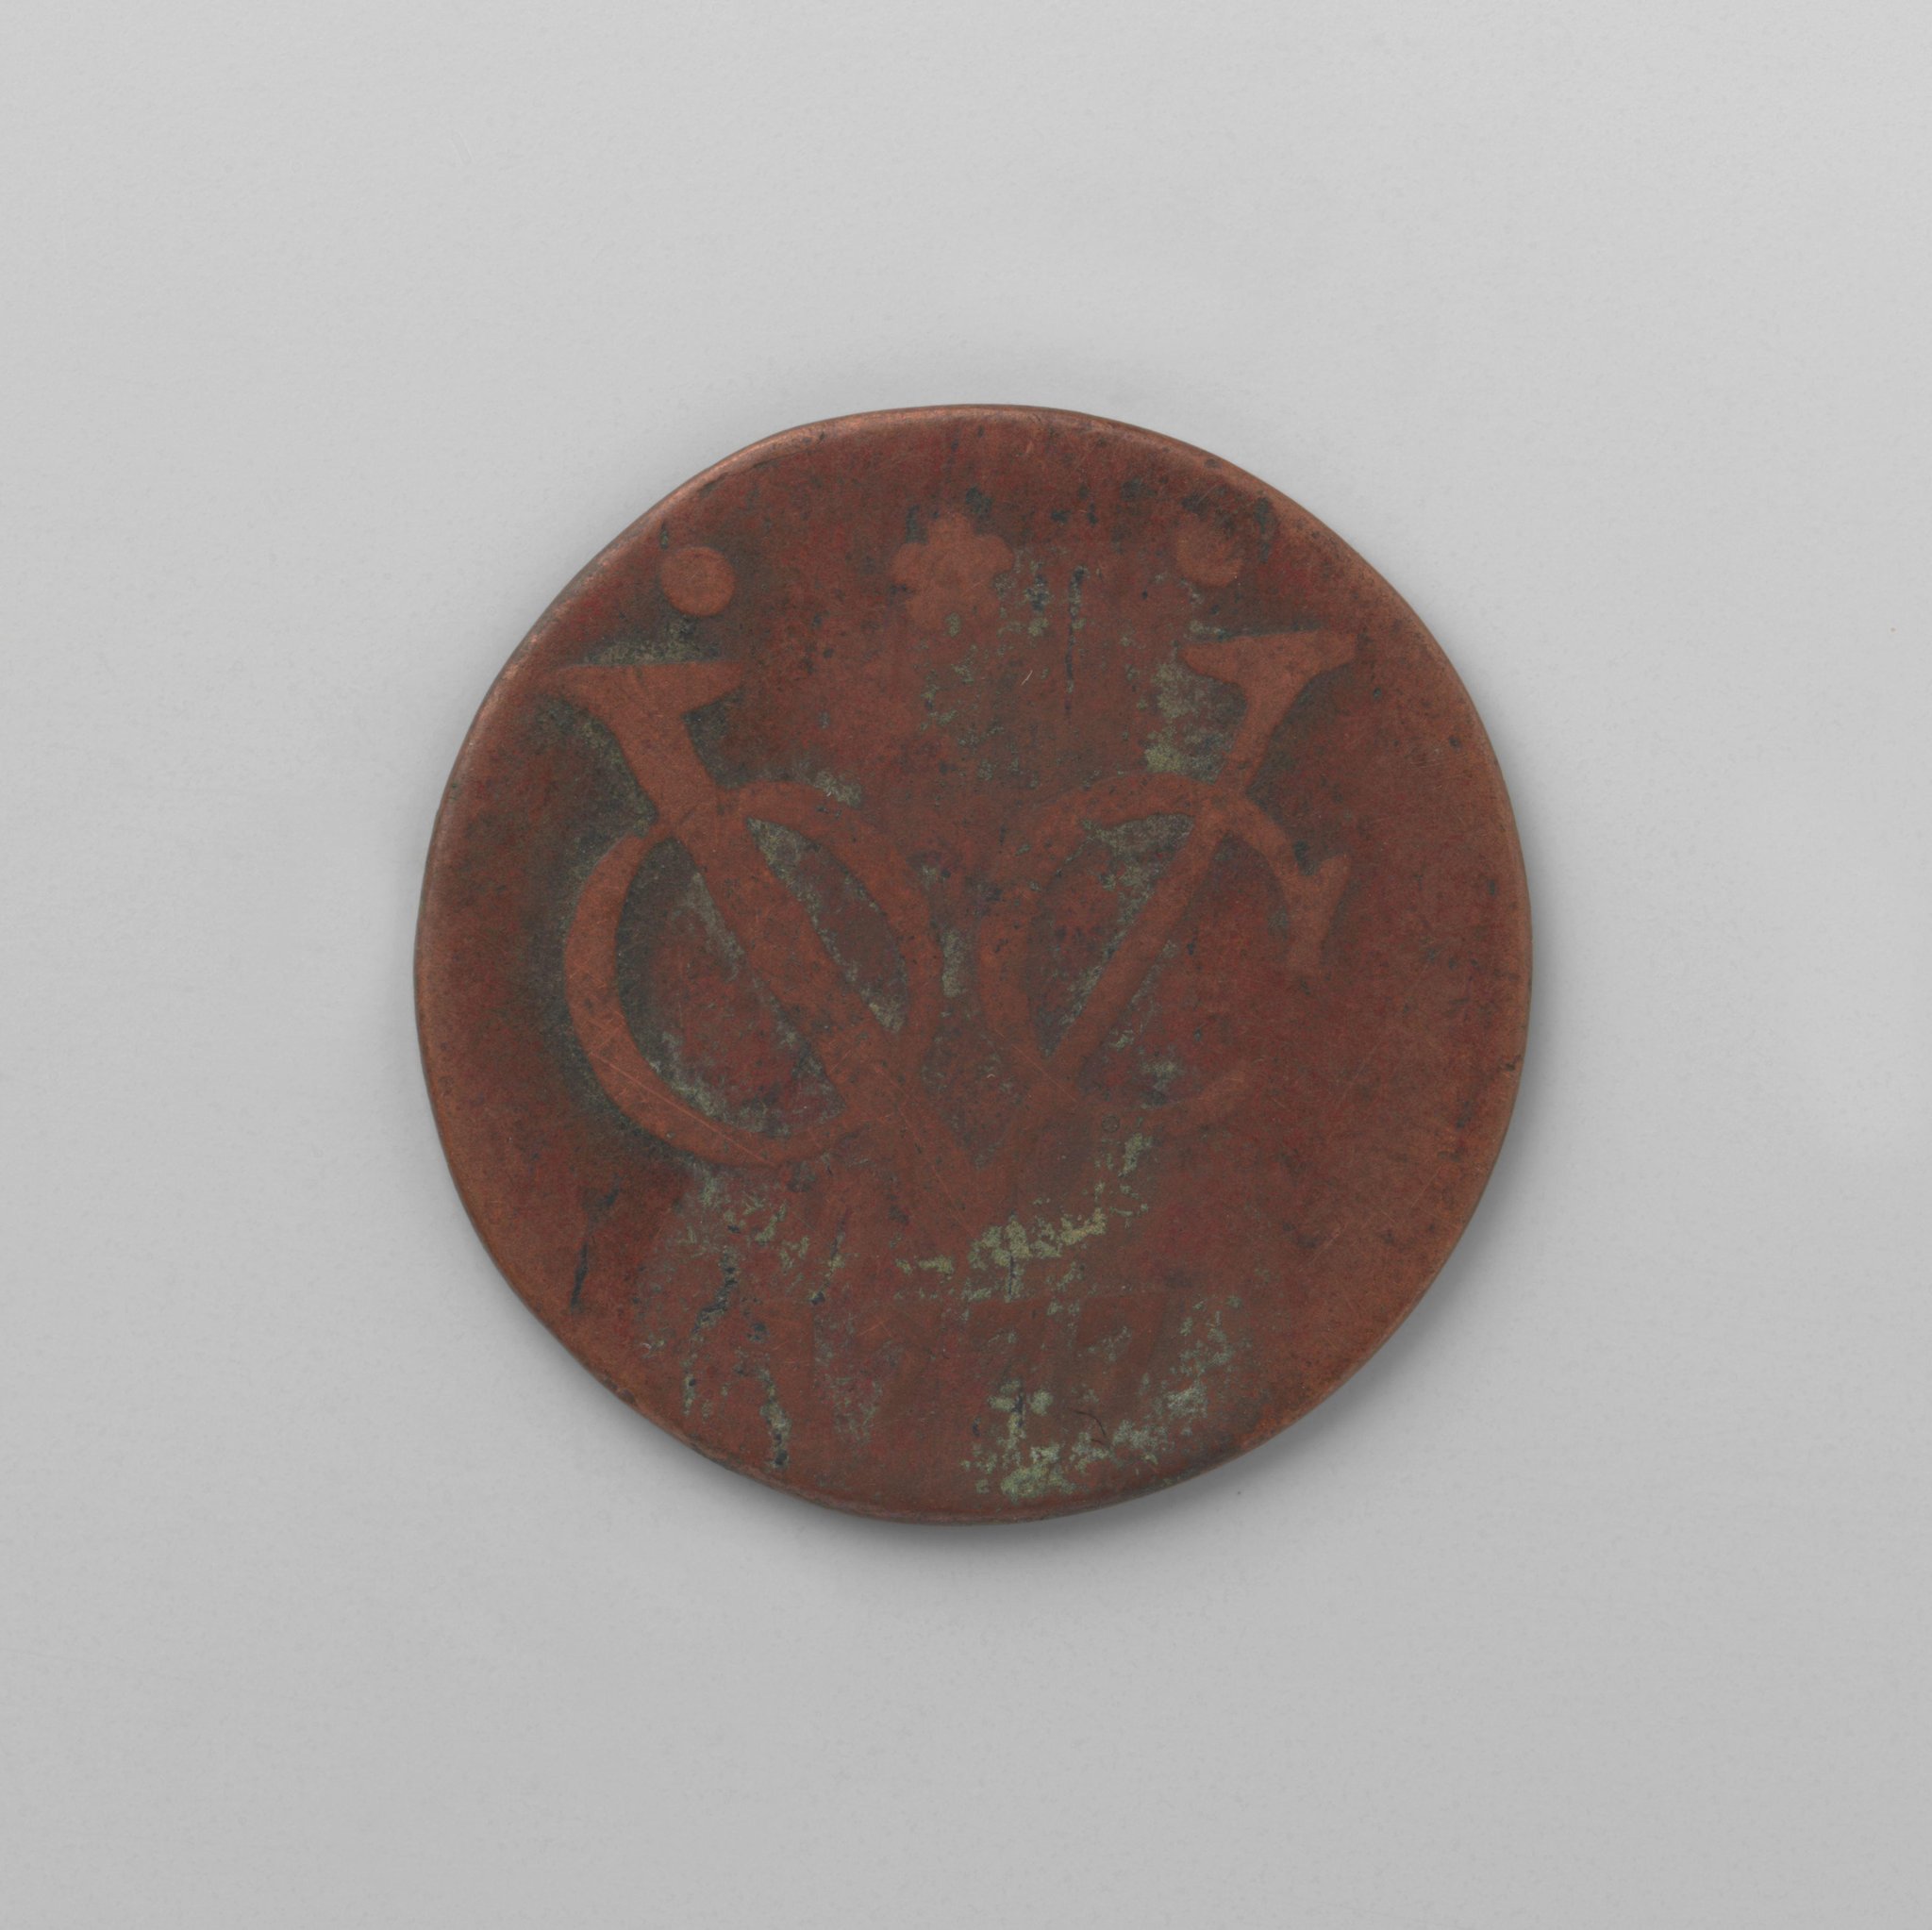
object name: coin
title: VOC, duit Westfriesland,1777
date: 1777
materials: copper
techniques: striking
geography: medemblik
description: Koperen munt. Voorzijde: gekroond wapenschild van Westfriesland. Keerzijde: monogram van de VOC, waarboven muntteken en waaronder jaartal. Gladde rand.